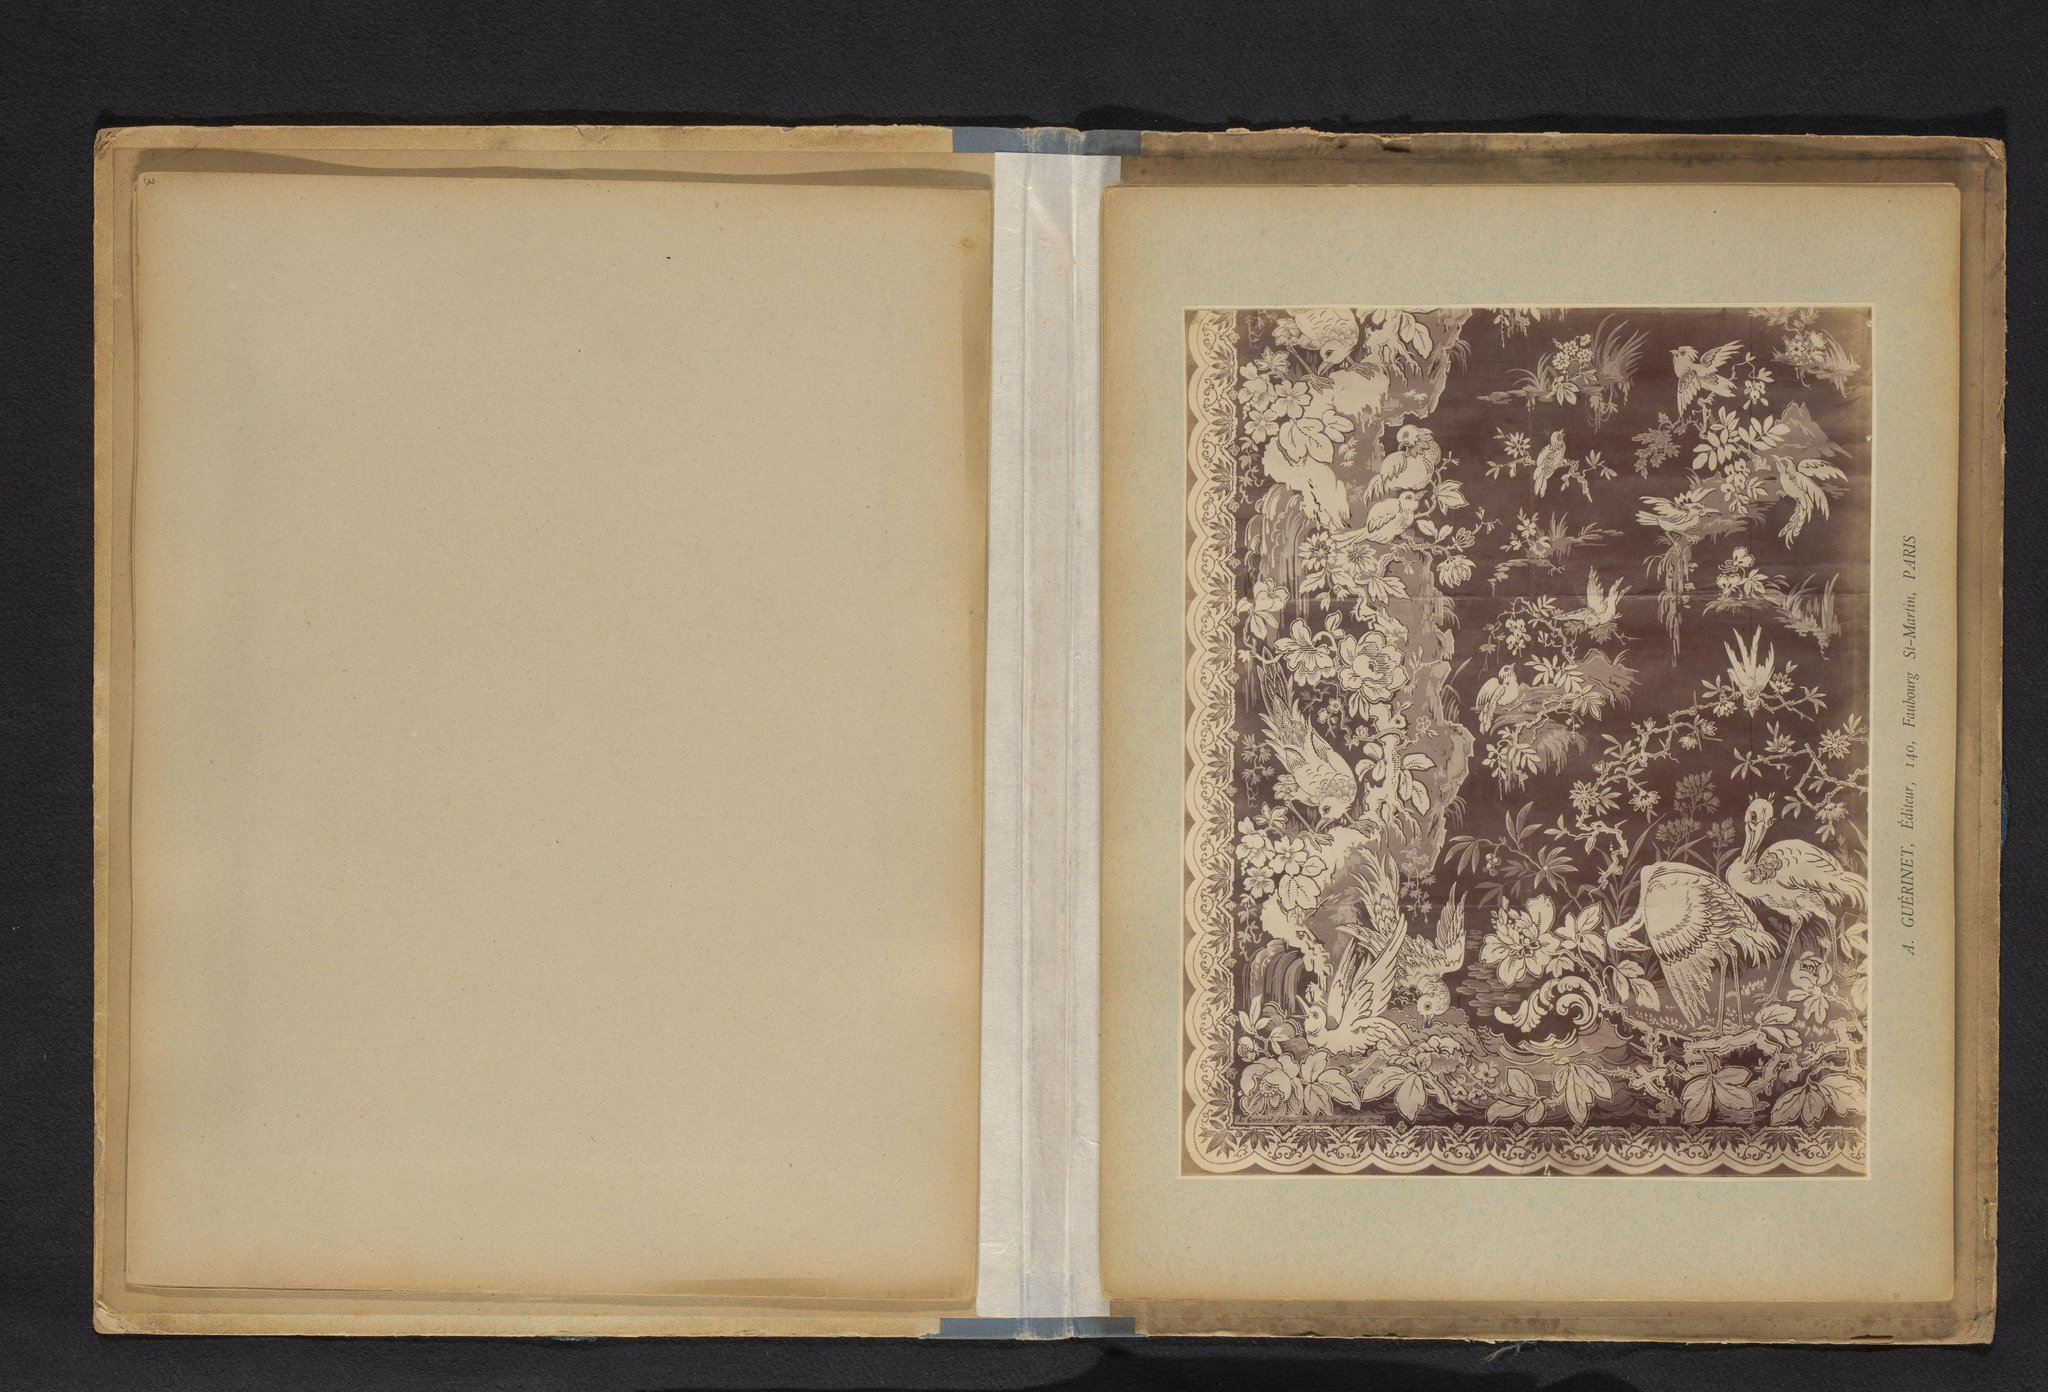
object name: photograph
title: Fotoreproductie van een decoratief patroon met bloemen en vogels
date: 1890-1900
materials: photographic support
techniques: albumen print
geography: paris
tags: other ornament derived from animal forms, flowers ~ ornament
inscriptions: number: ‘4’